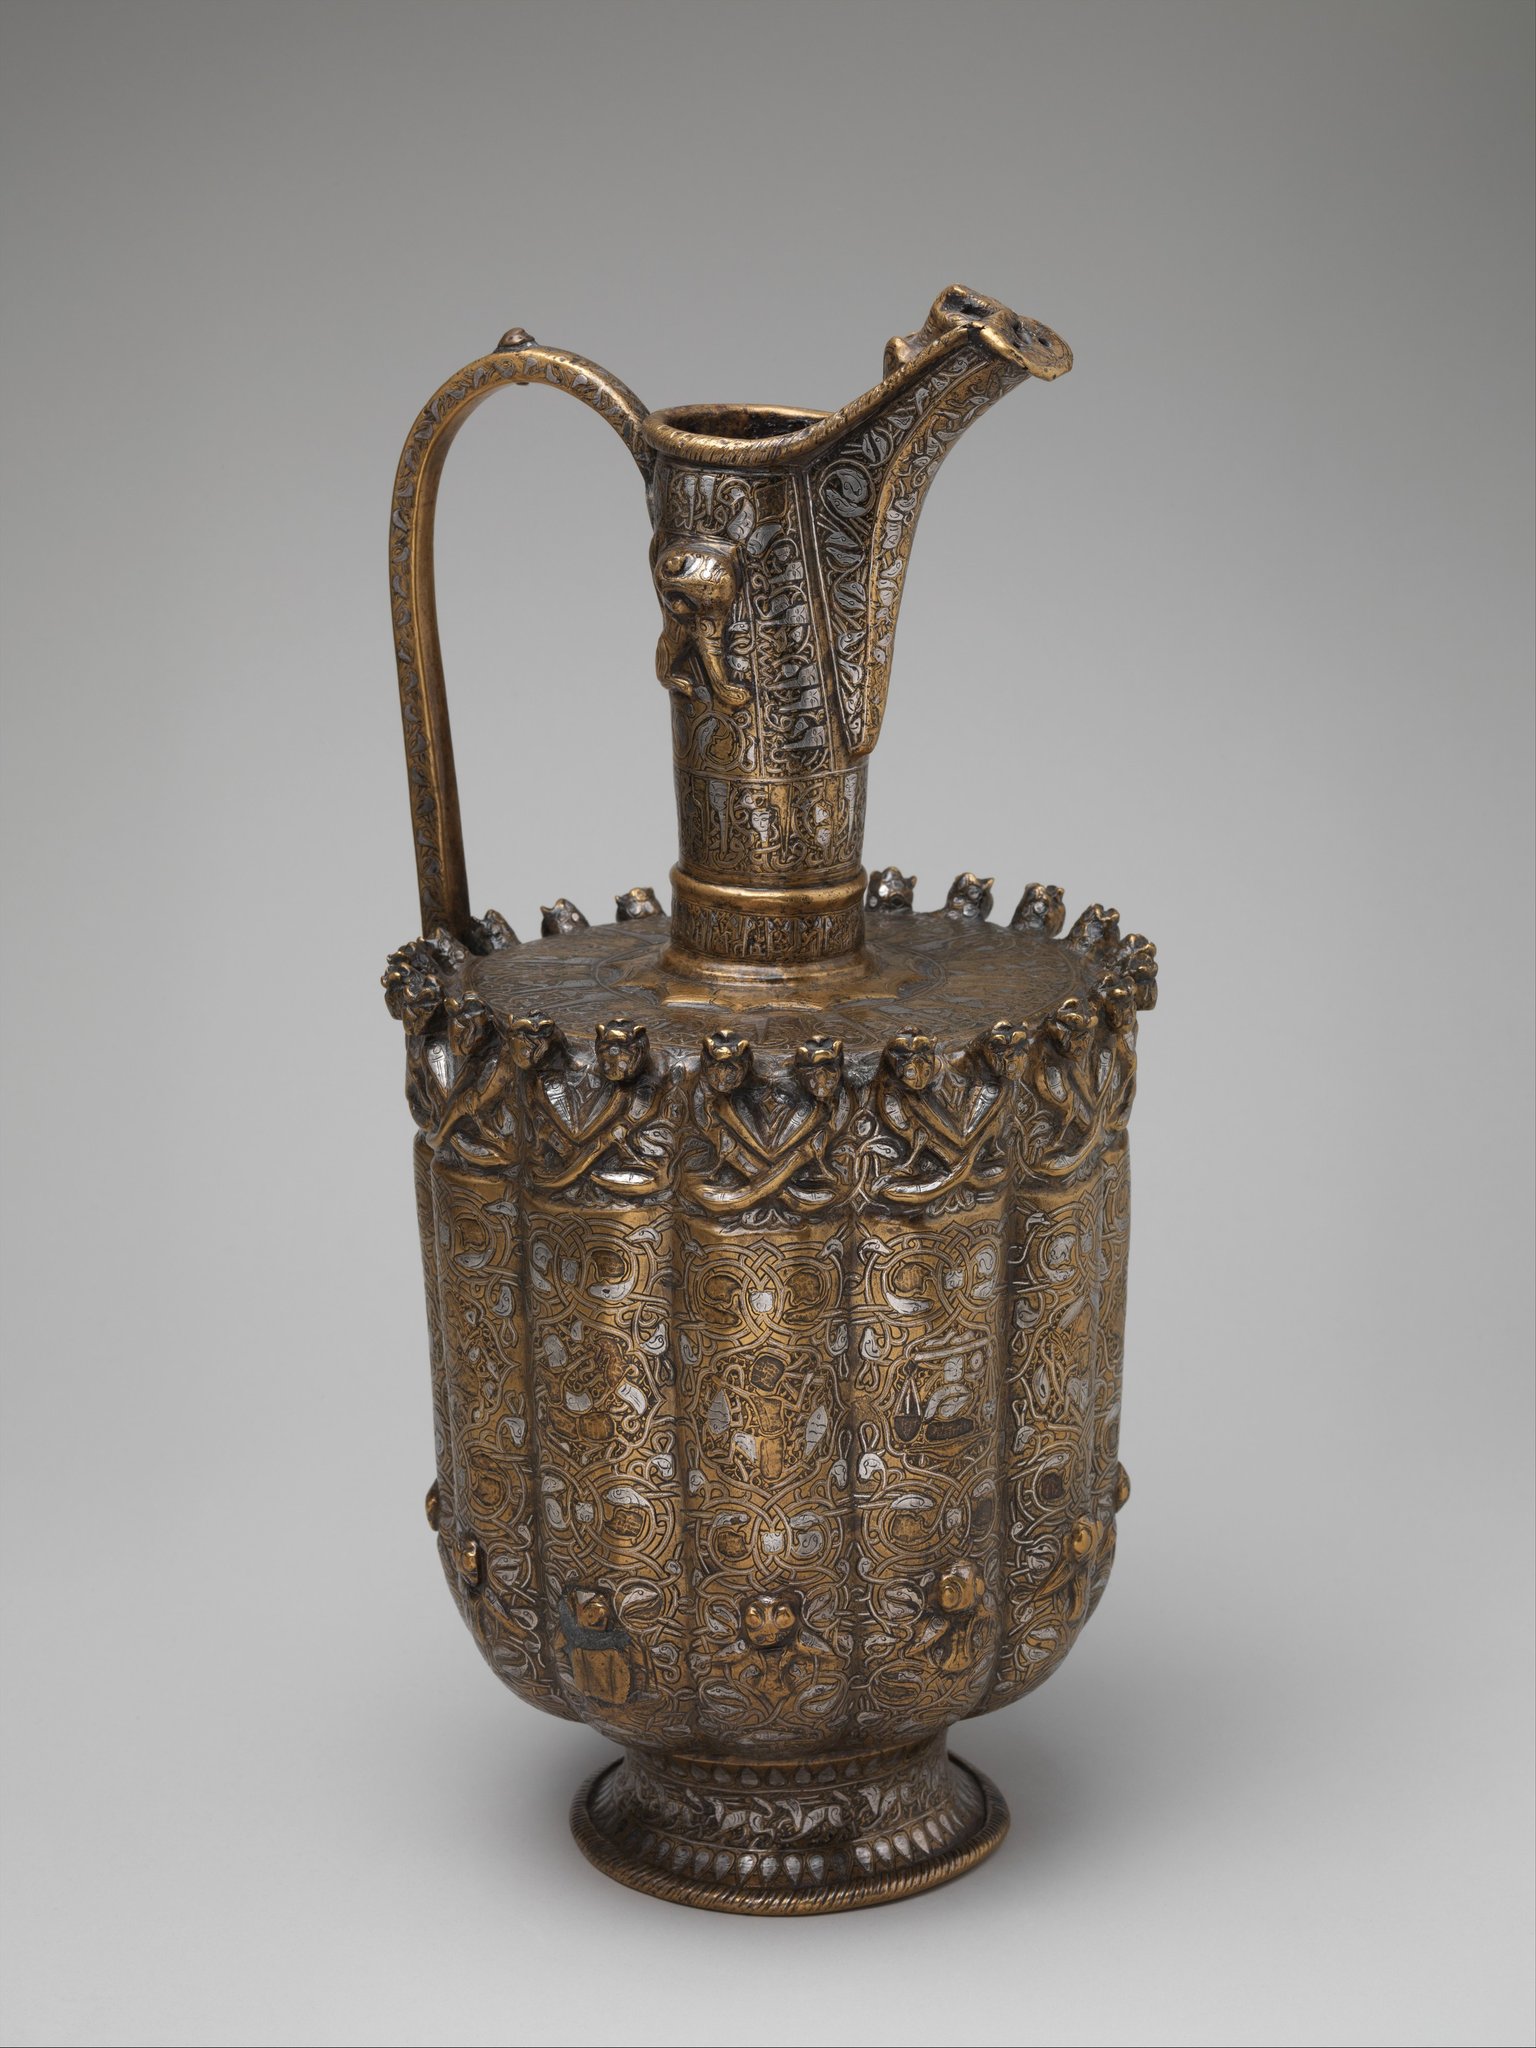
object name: ewer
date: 1180-1210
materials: brass, silver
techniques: inlay, repoussé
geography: afghanistan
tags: zodiac